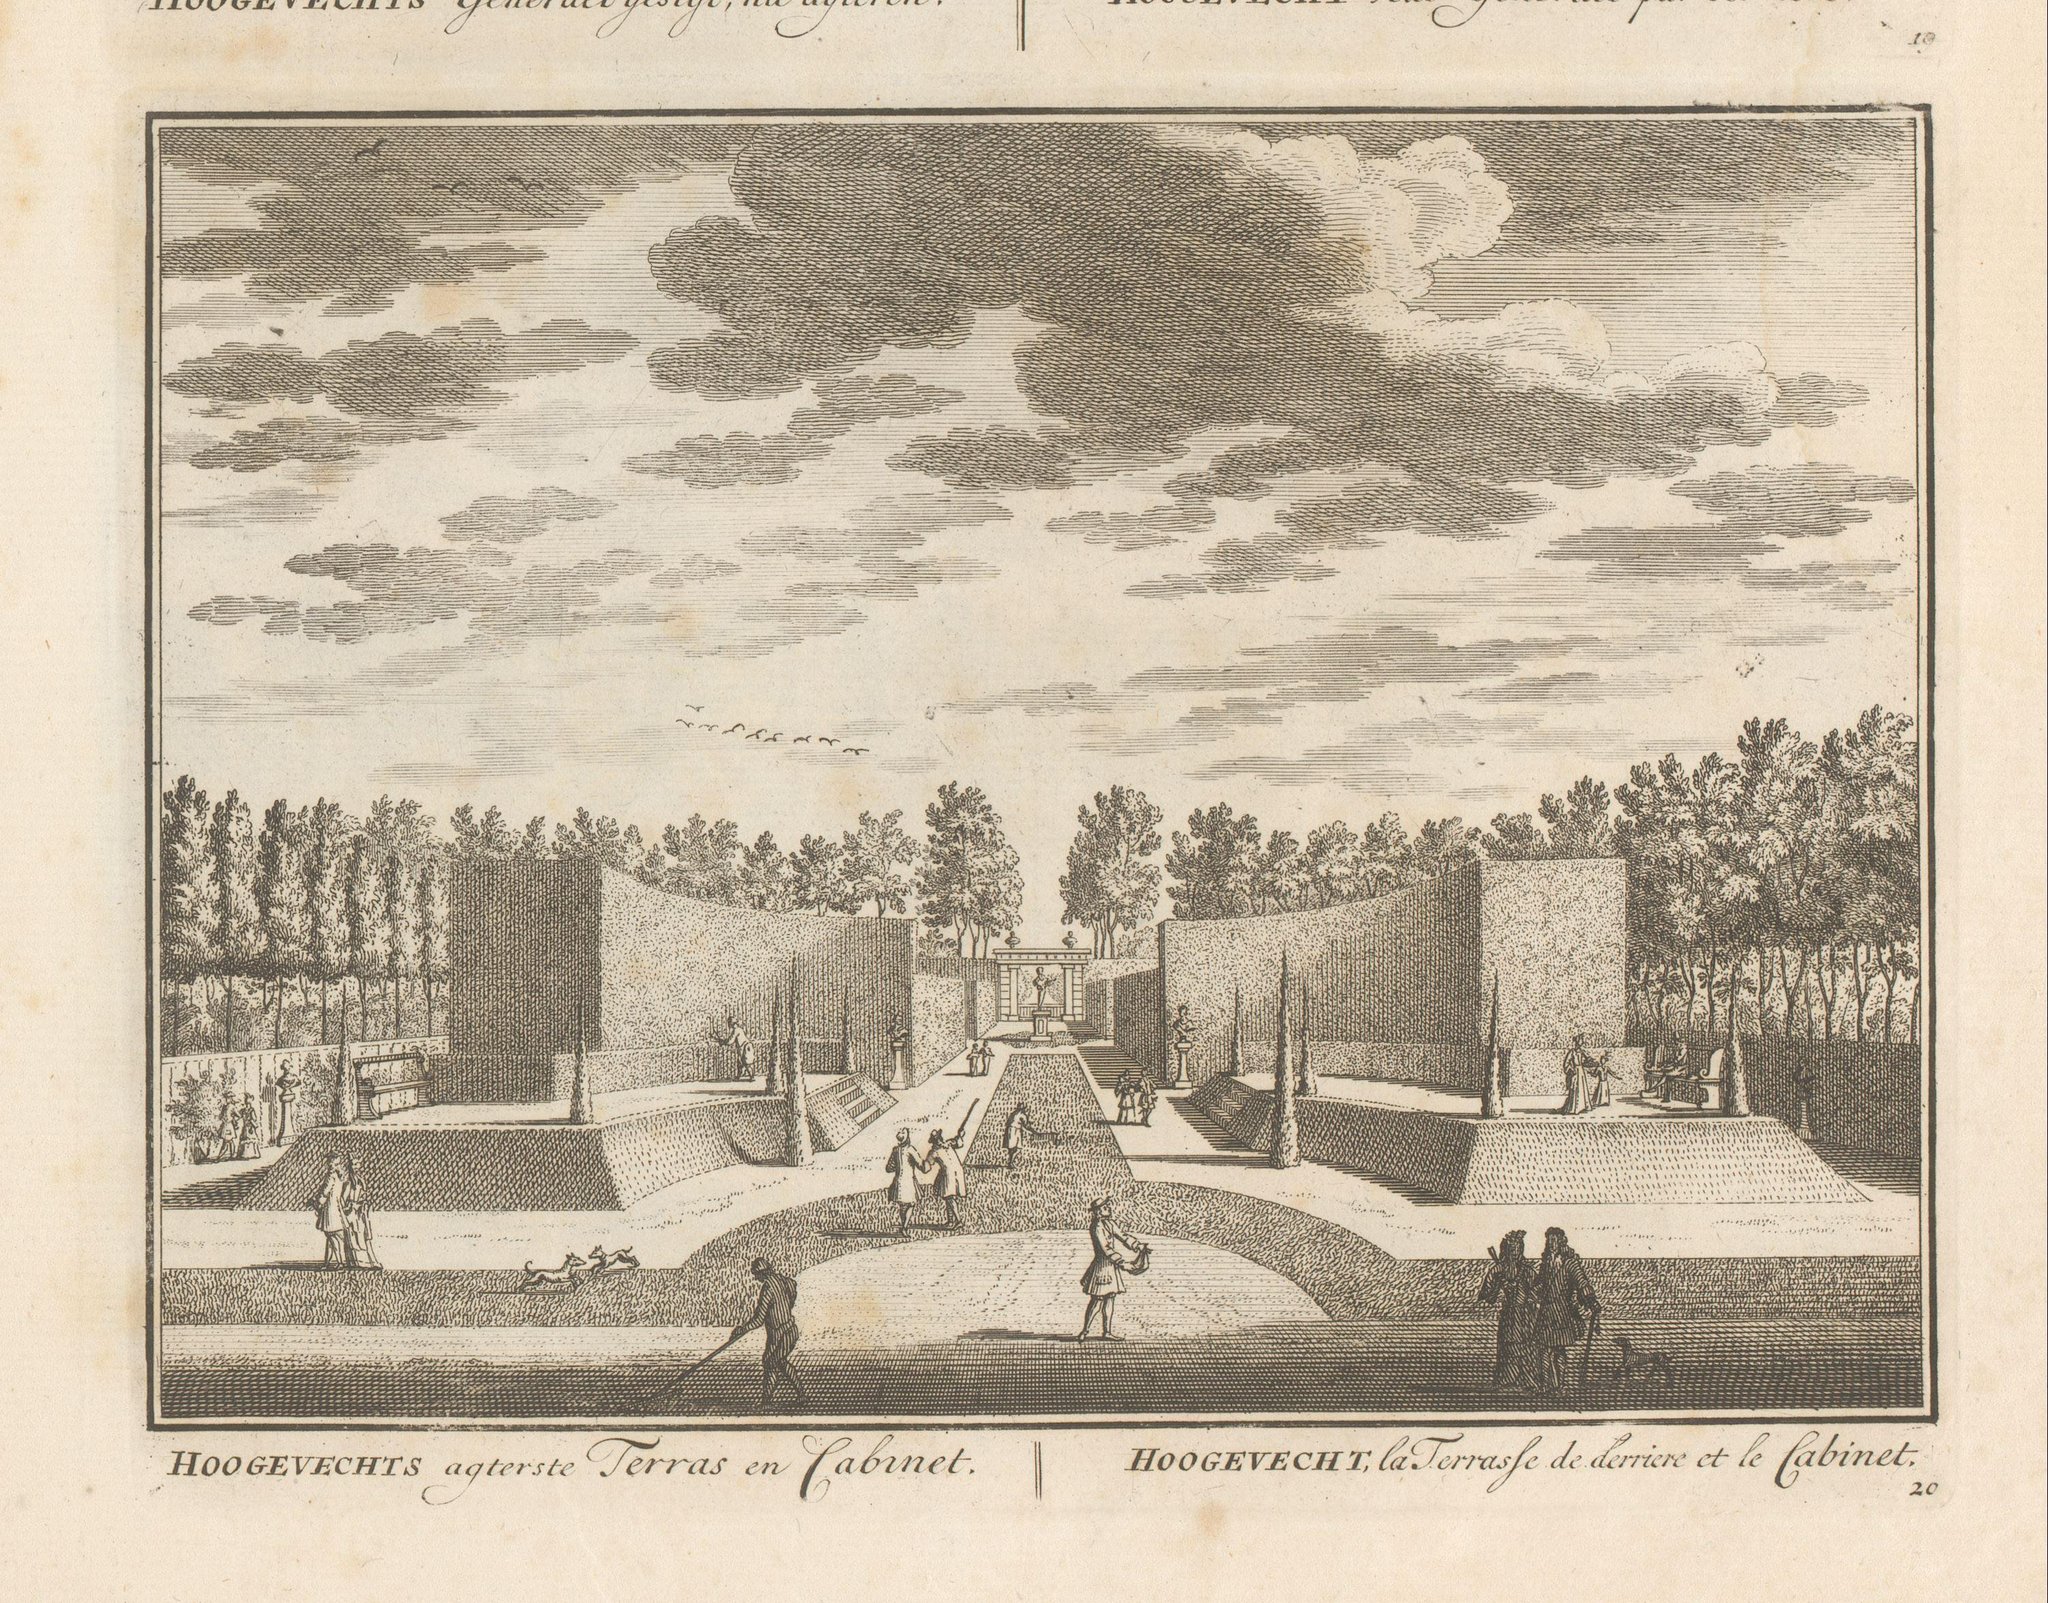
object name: album leaf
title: Gezicht op de tuin van buitenplaats Hoogevecht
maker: daniël stopendaal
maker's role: print maker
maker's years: 1672-1726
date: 1790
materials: paper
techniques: engraving, etching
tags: french or architectonic garden; formal garden, river (+ landscape with figures, staffage), maarssen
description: Prent gebruikt in: Leth, Andries de. De zegepraalende Vecht, vertoonende verscheidene gesichten van lustplaatsen, heeren huysen en dorpen, beginnende van Uitrecht en met Muyden besluytende (...). Amsterdam: Weduwe Nicolaus Visscher, 1719. Prent ook gebruikt in: Brouërius van Nidek, Matthaeus. De Vechtstroom, van Utrecht tot Muiden (...). Amsterdam: H. Gartman, W. Vermandel en J.W. Smit, 1790.